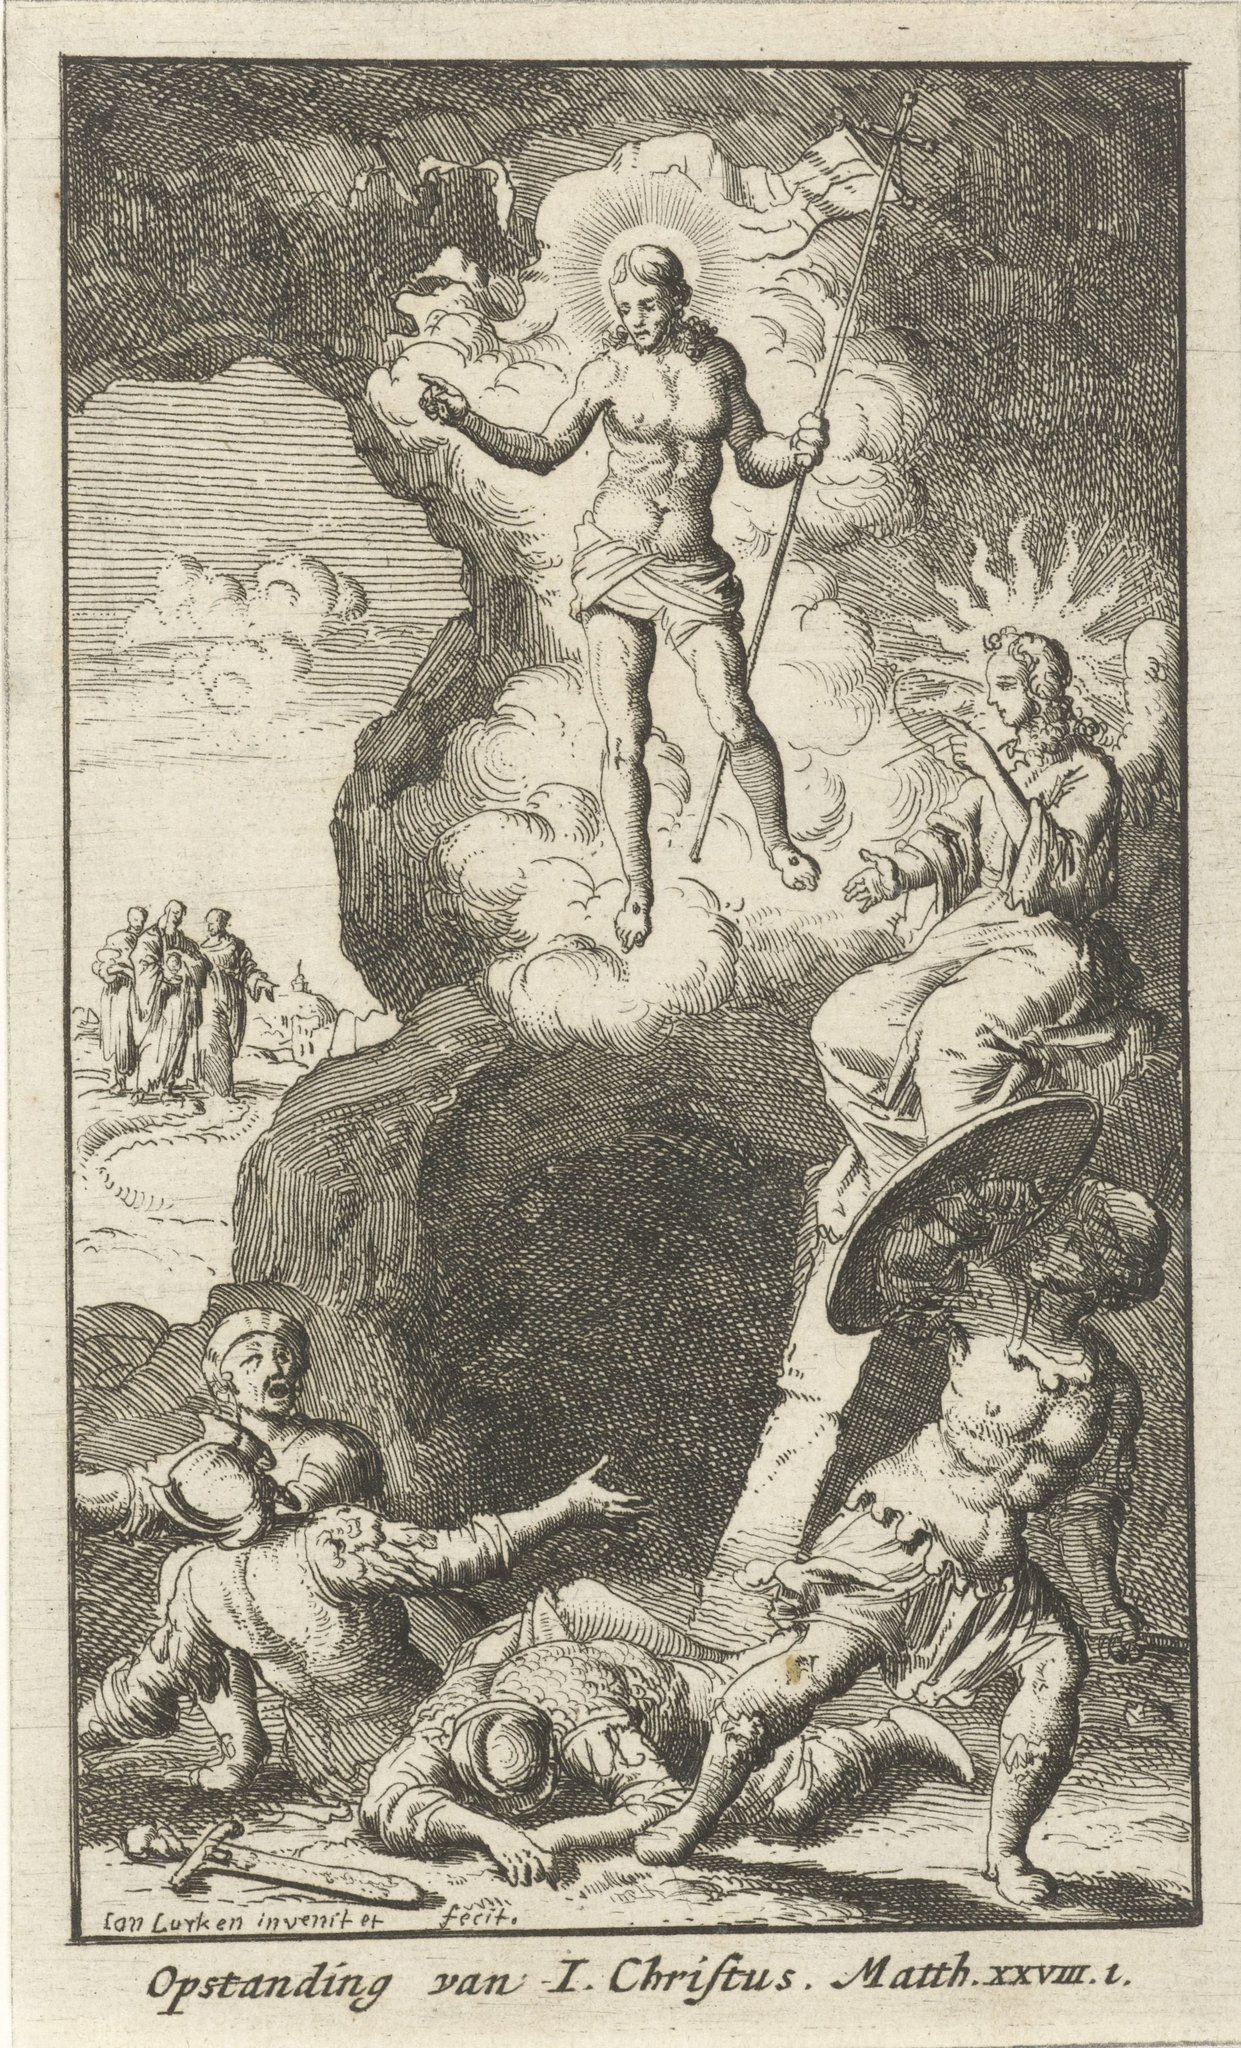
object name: print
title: Vierentwintig scènes uit het Nieuwe Testament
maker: jan luyken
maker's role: draughtsman, print maker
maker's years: 1649-1712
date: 1681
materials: paper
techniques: etching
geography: amsterdam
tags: christ, usually holding a banner, arises from the grave; often combined with sleeping and/or frightened soldiers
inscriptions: collector's mark: Lugt 2228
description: Twintig prenten van deze serie (waaronder de hier besproken prent) verschenen mogelijk voor het eerst in: Het Nieuwe Testament ofte alle Boecken des Nieuwen Verbondts onses Heeren Iesu Christi. Amsterdam: Hieronymus Sweerts, Jan ten Hoorn, Jan Bouman en Daniel van den Dalen, 1681. De complete vierentwintigdelige serie prenten is opgenomen in: Het Nieuwe Testament ofte alle Boecken des Nieuwen Verbondts onses Heeren Iesu Christi. Dordrecht: Pieter en Jacob Keur, 172X (niet voor 1727). De prenten werden, hetzij alle tezamen, hetzij gedeeltelijk, veel gebruikt tot versiering van Nieuwe Testamenten en verschenen tevens in kopie.